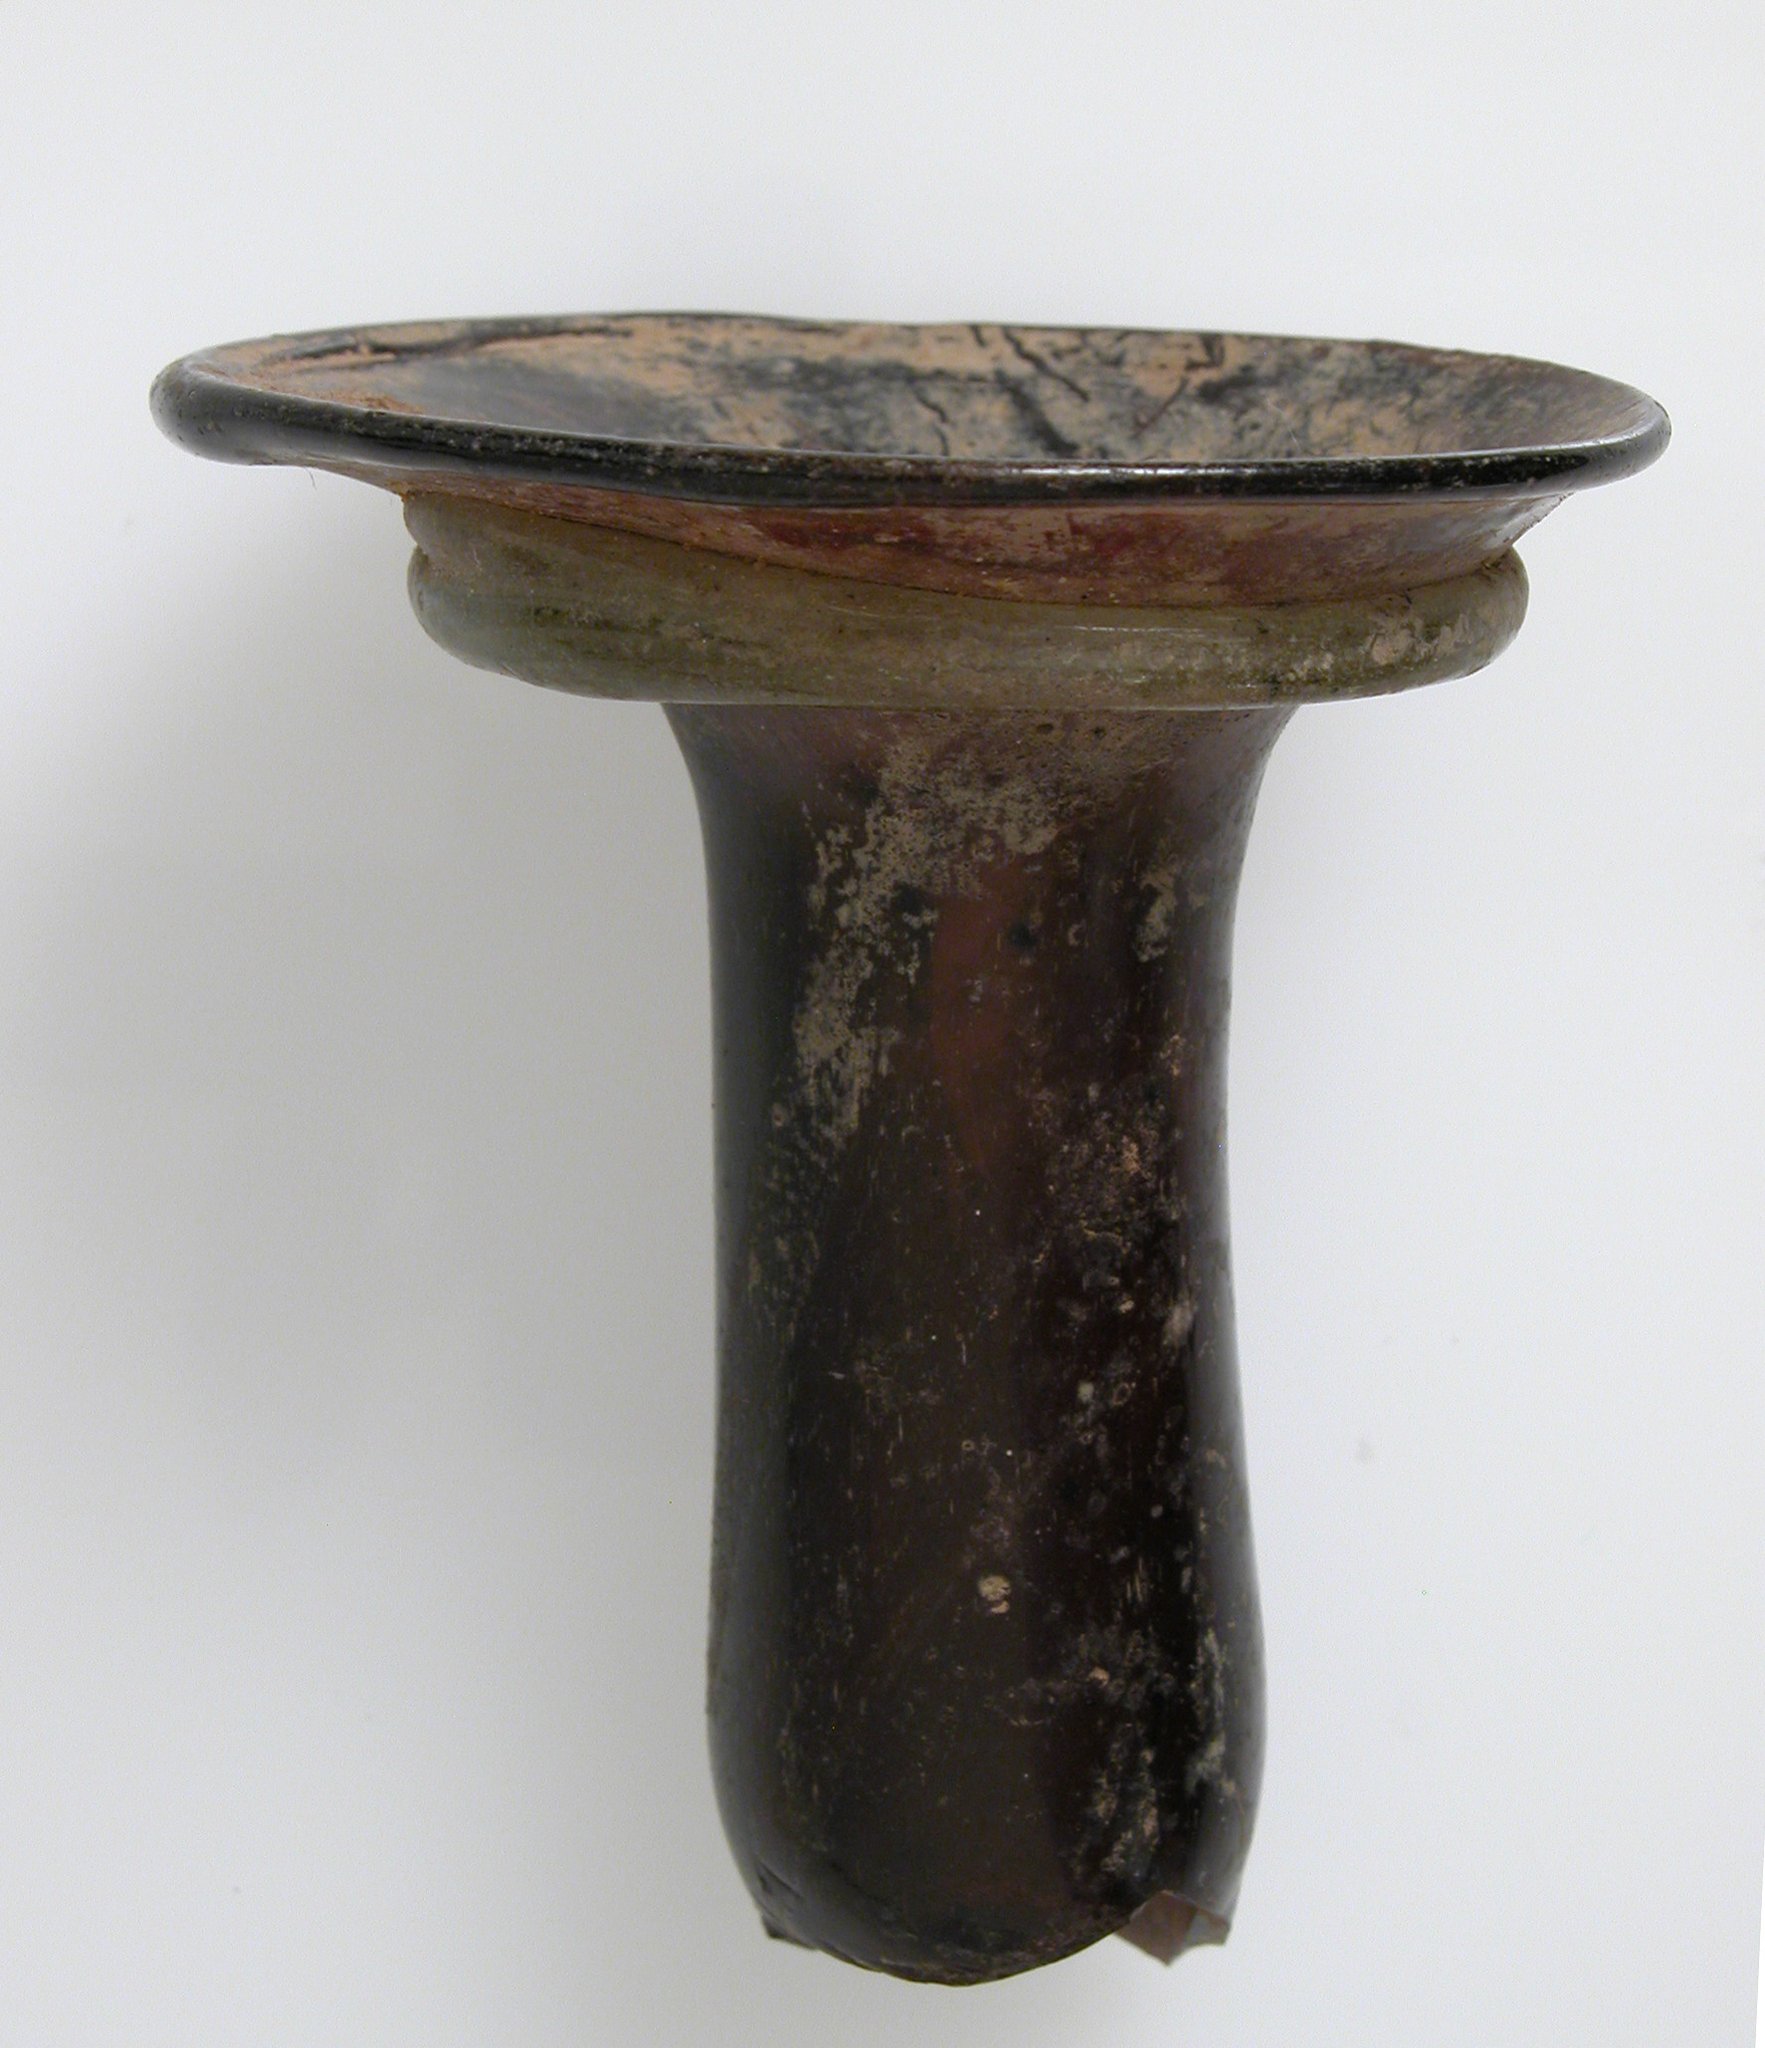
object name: fragment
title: Neck of a Bottle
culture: coptic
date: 301-433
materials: glass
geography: egypt